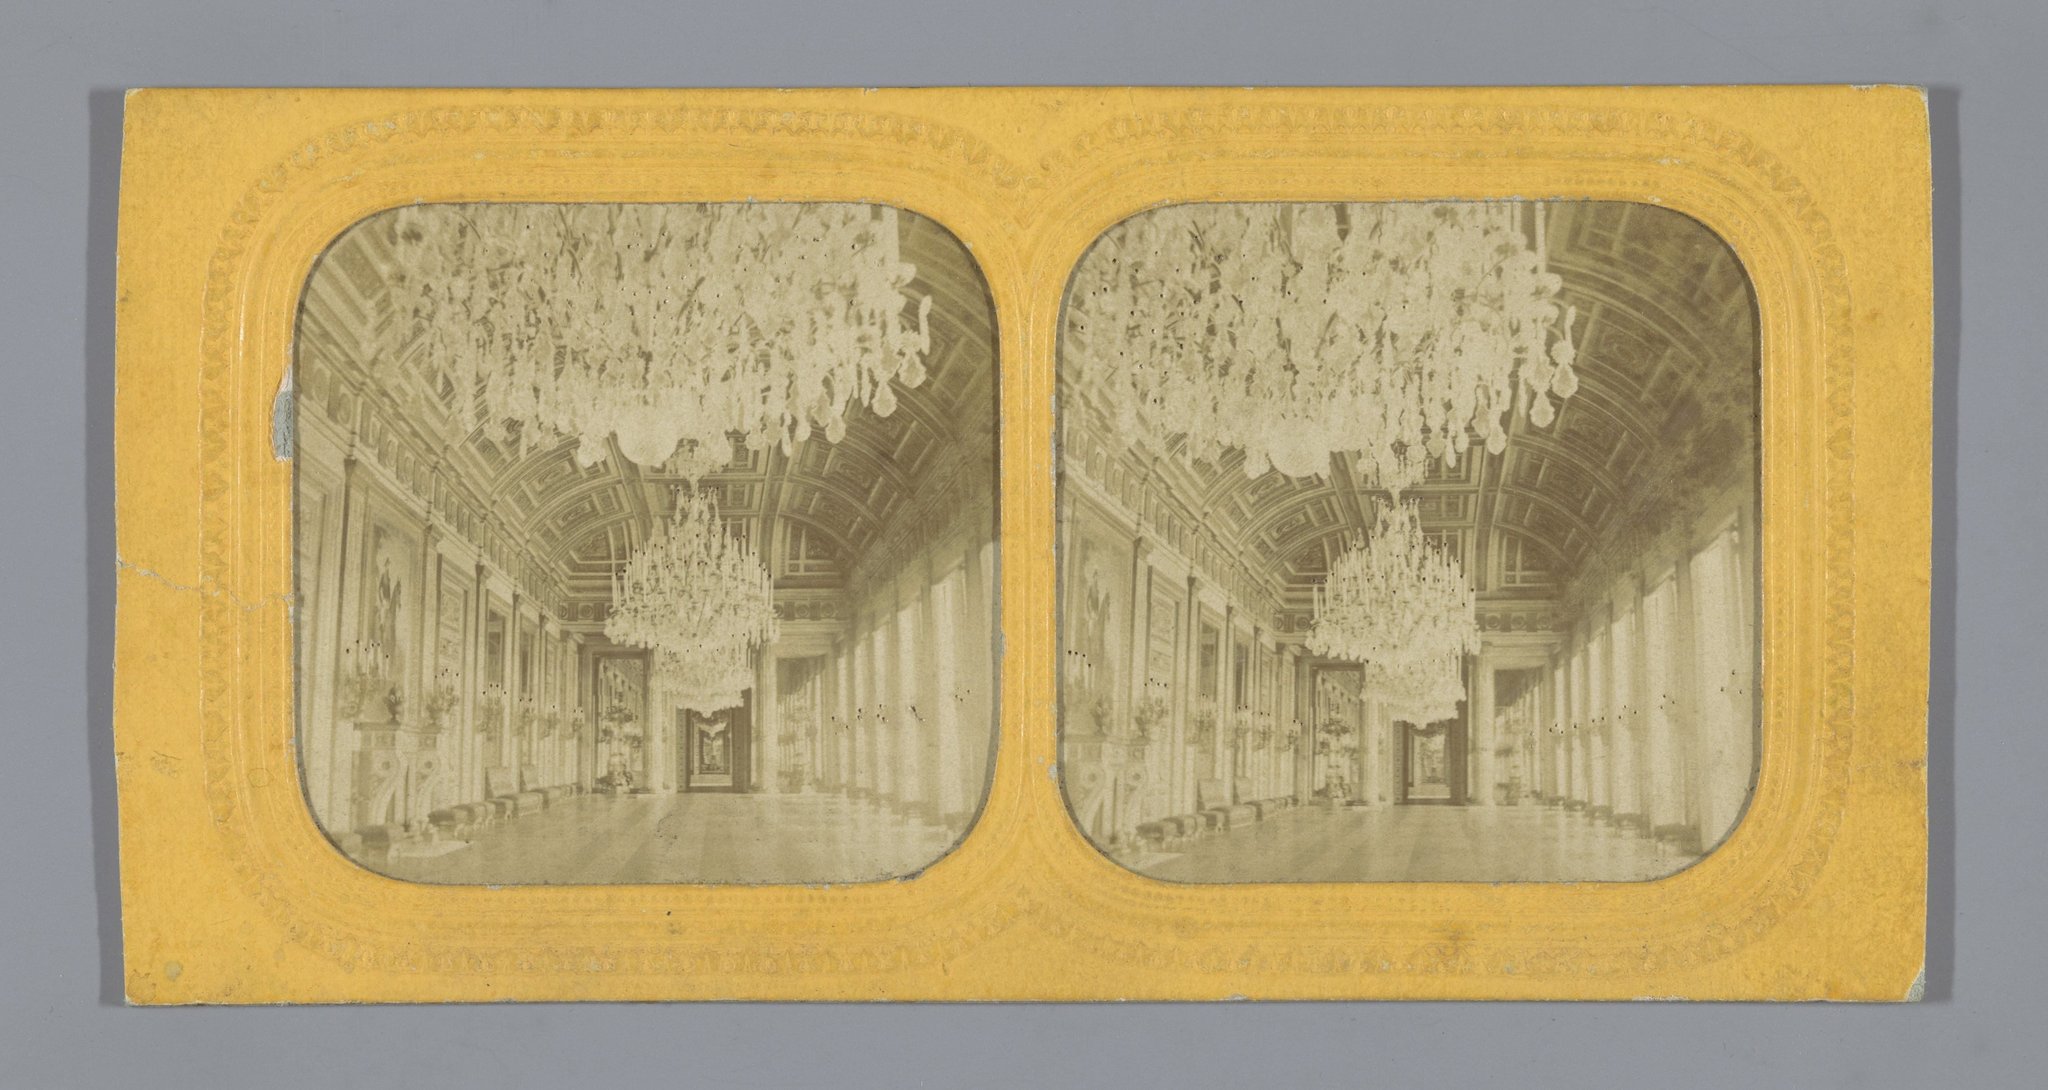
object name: tissue stereograph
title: Salon de la Paix, Tuileries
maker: Anonymous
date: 1855-1871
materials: cardboard, paper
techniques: albumen print, hand coloring, perforating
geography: paris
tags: palace - aa - civic architecture: inside, tuileries palace